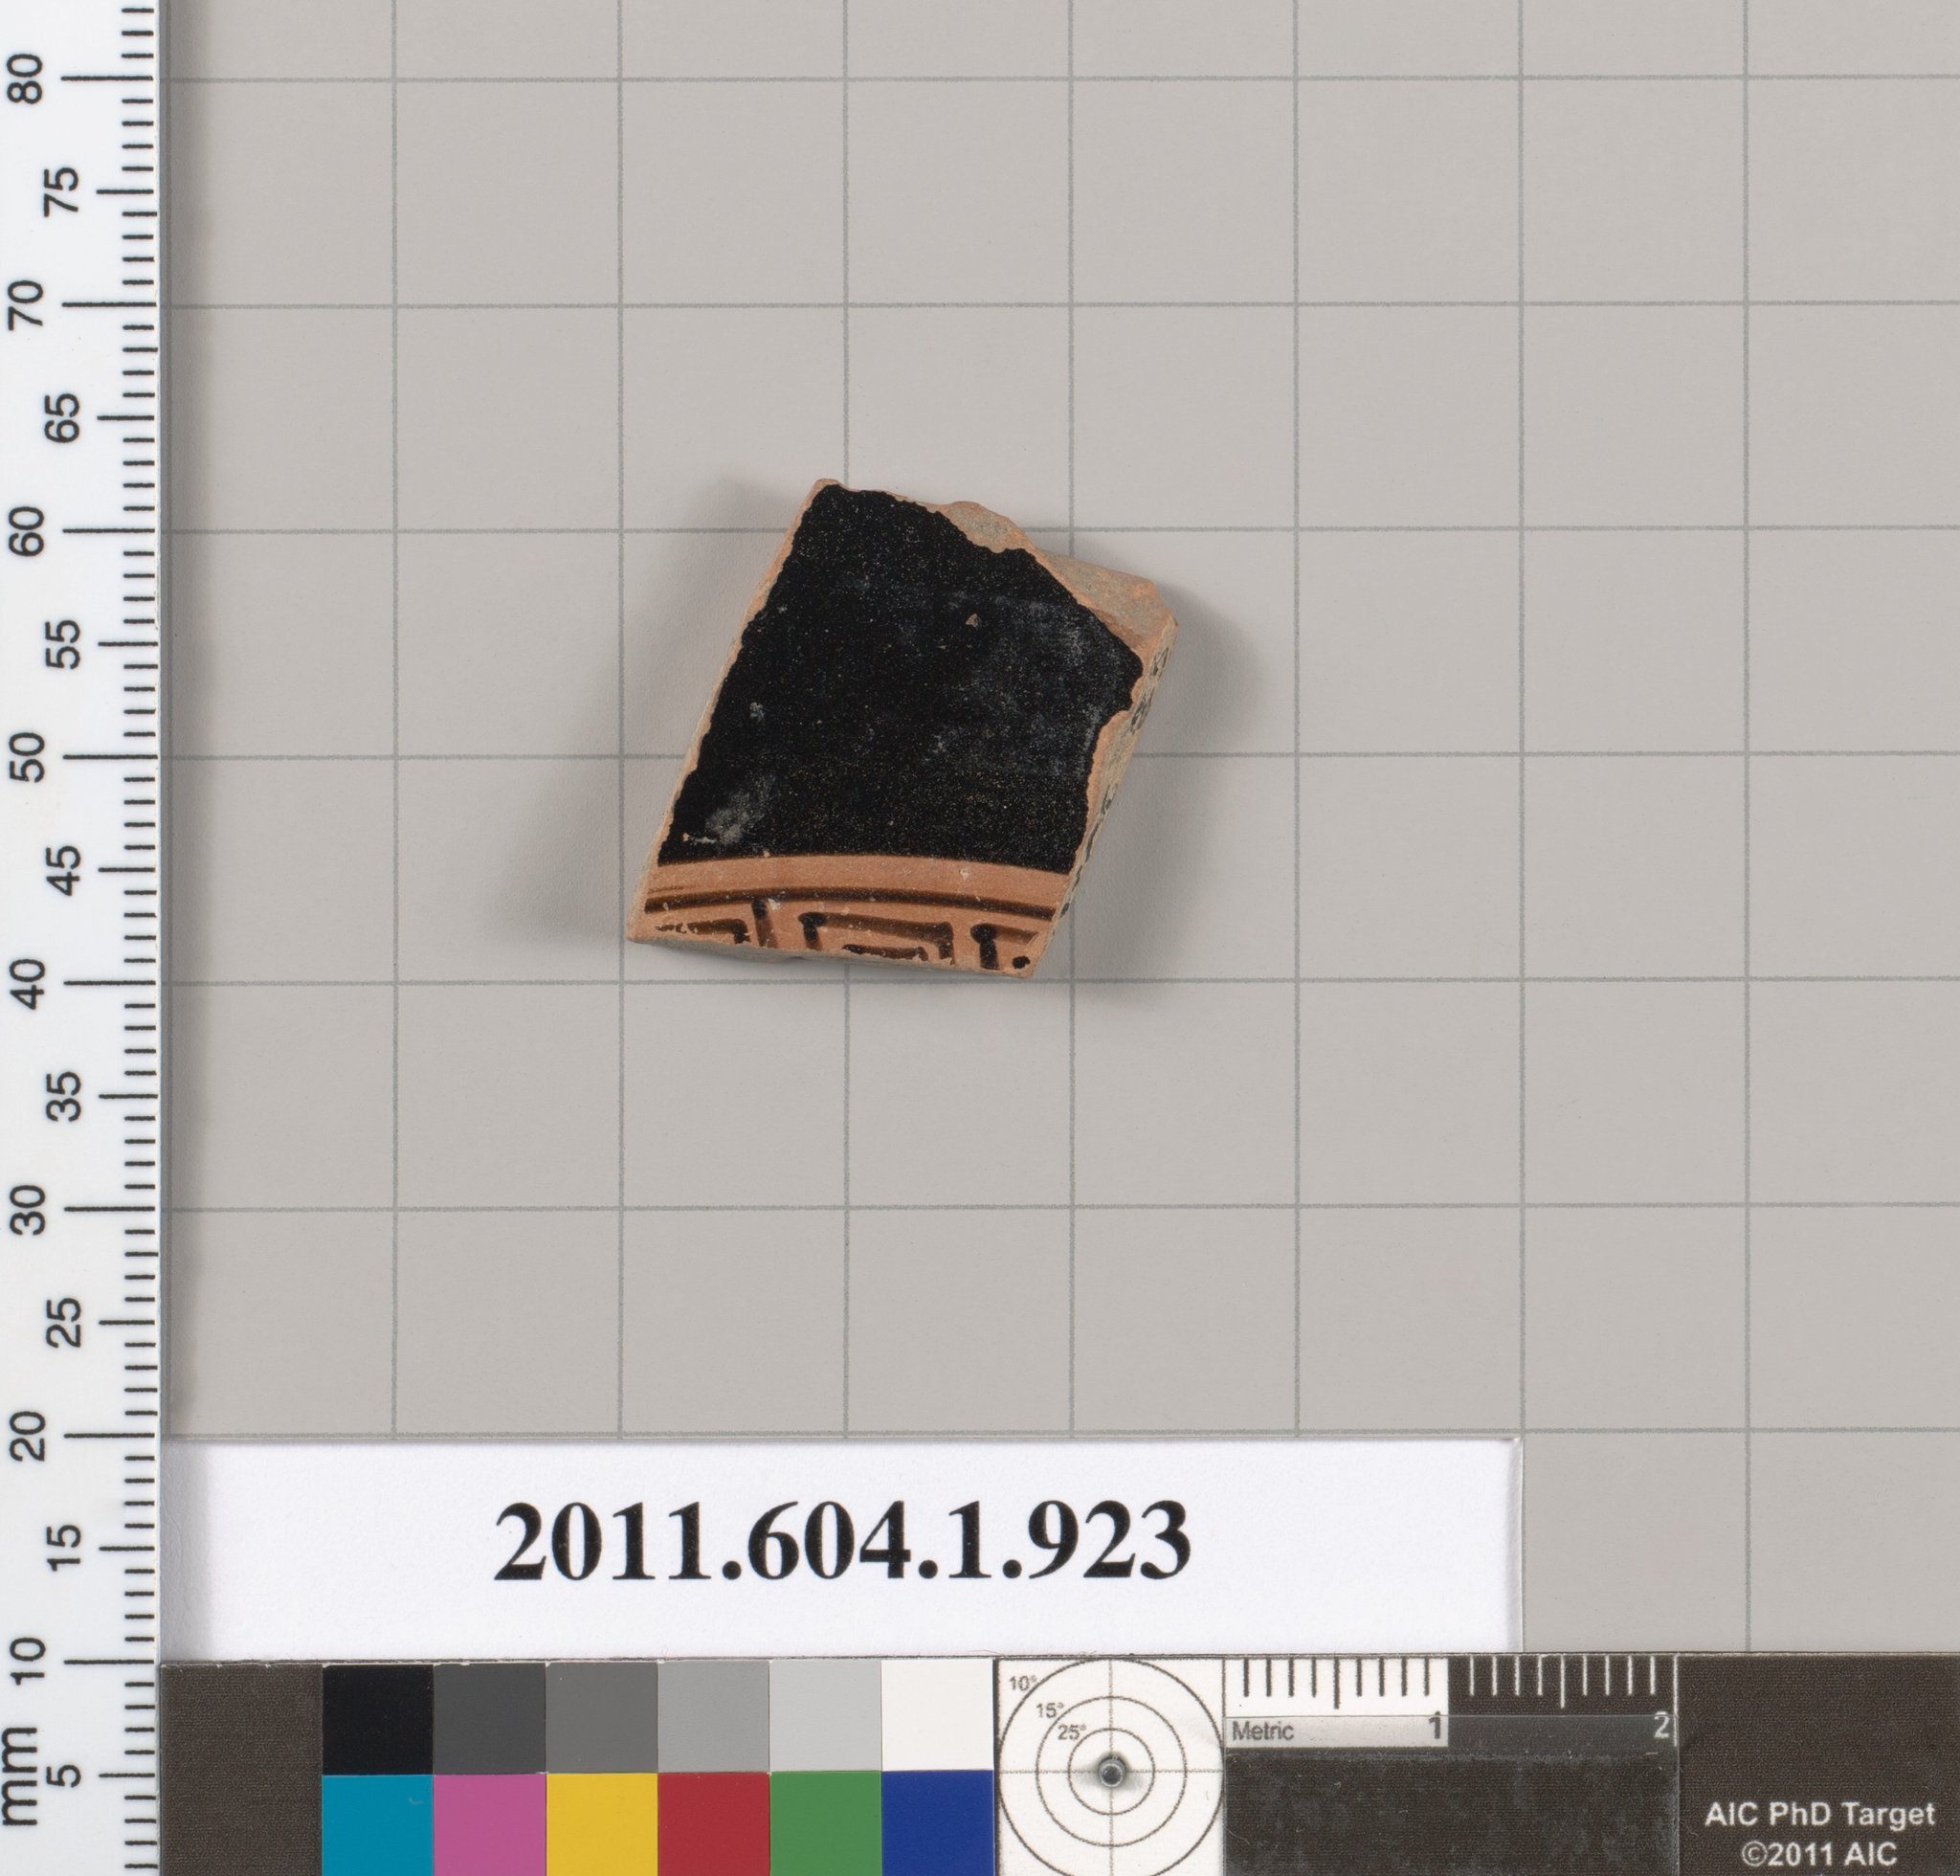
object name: kylix fragment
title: Terracotta fragment of a kylix (drinking cup)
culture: greek, attic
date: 490-480 BCE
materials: terracotta